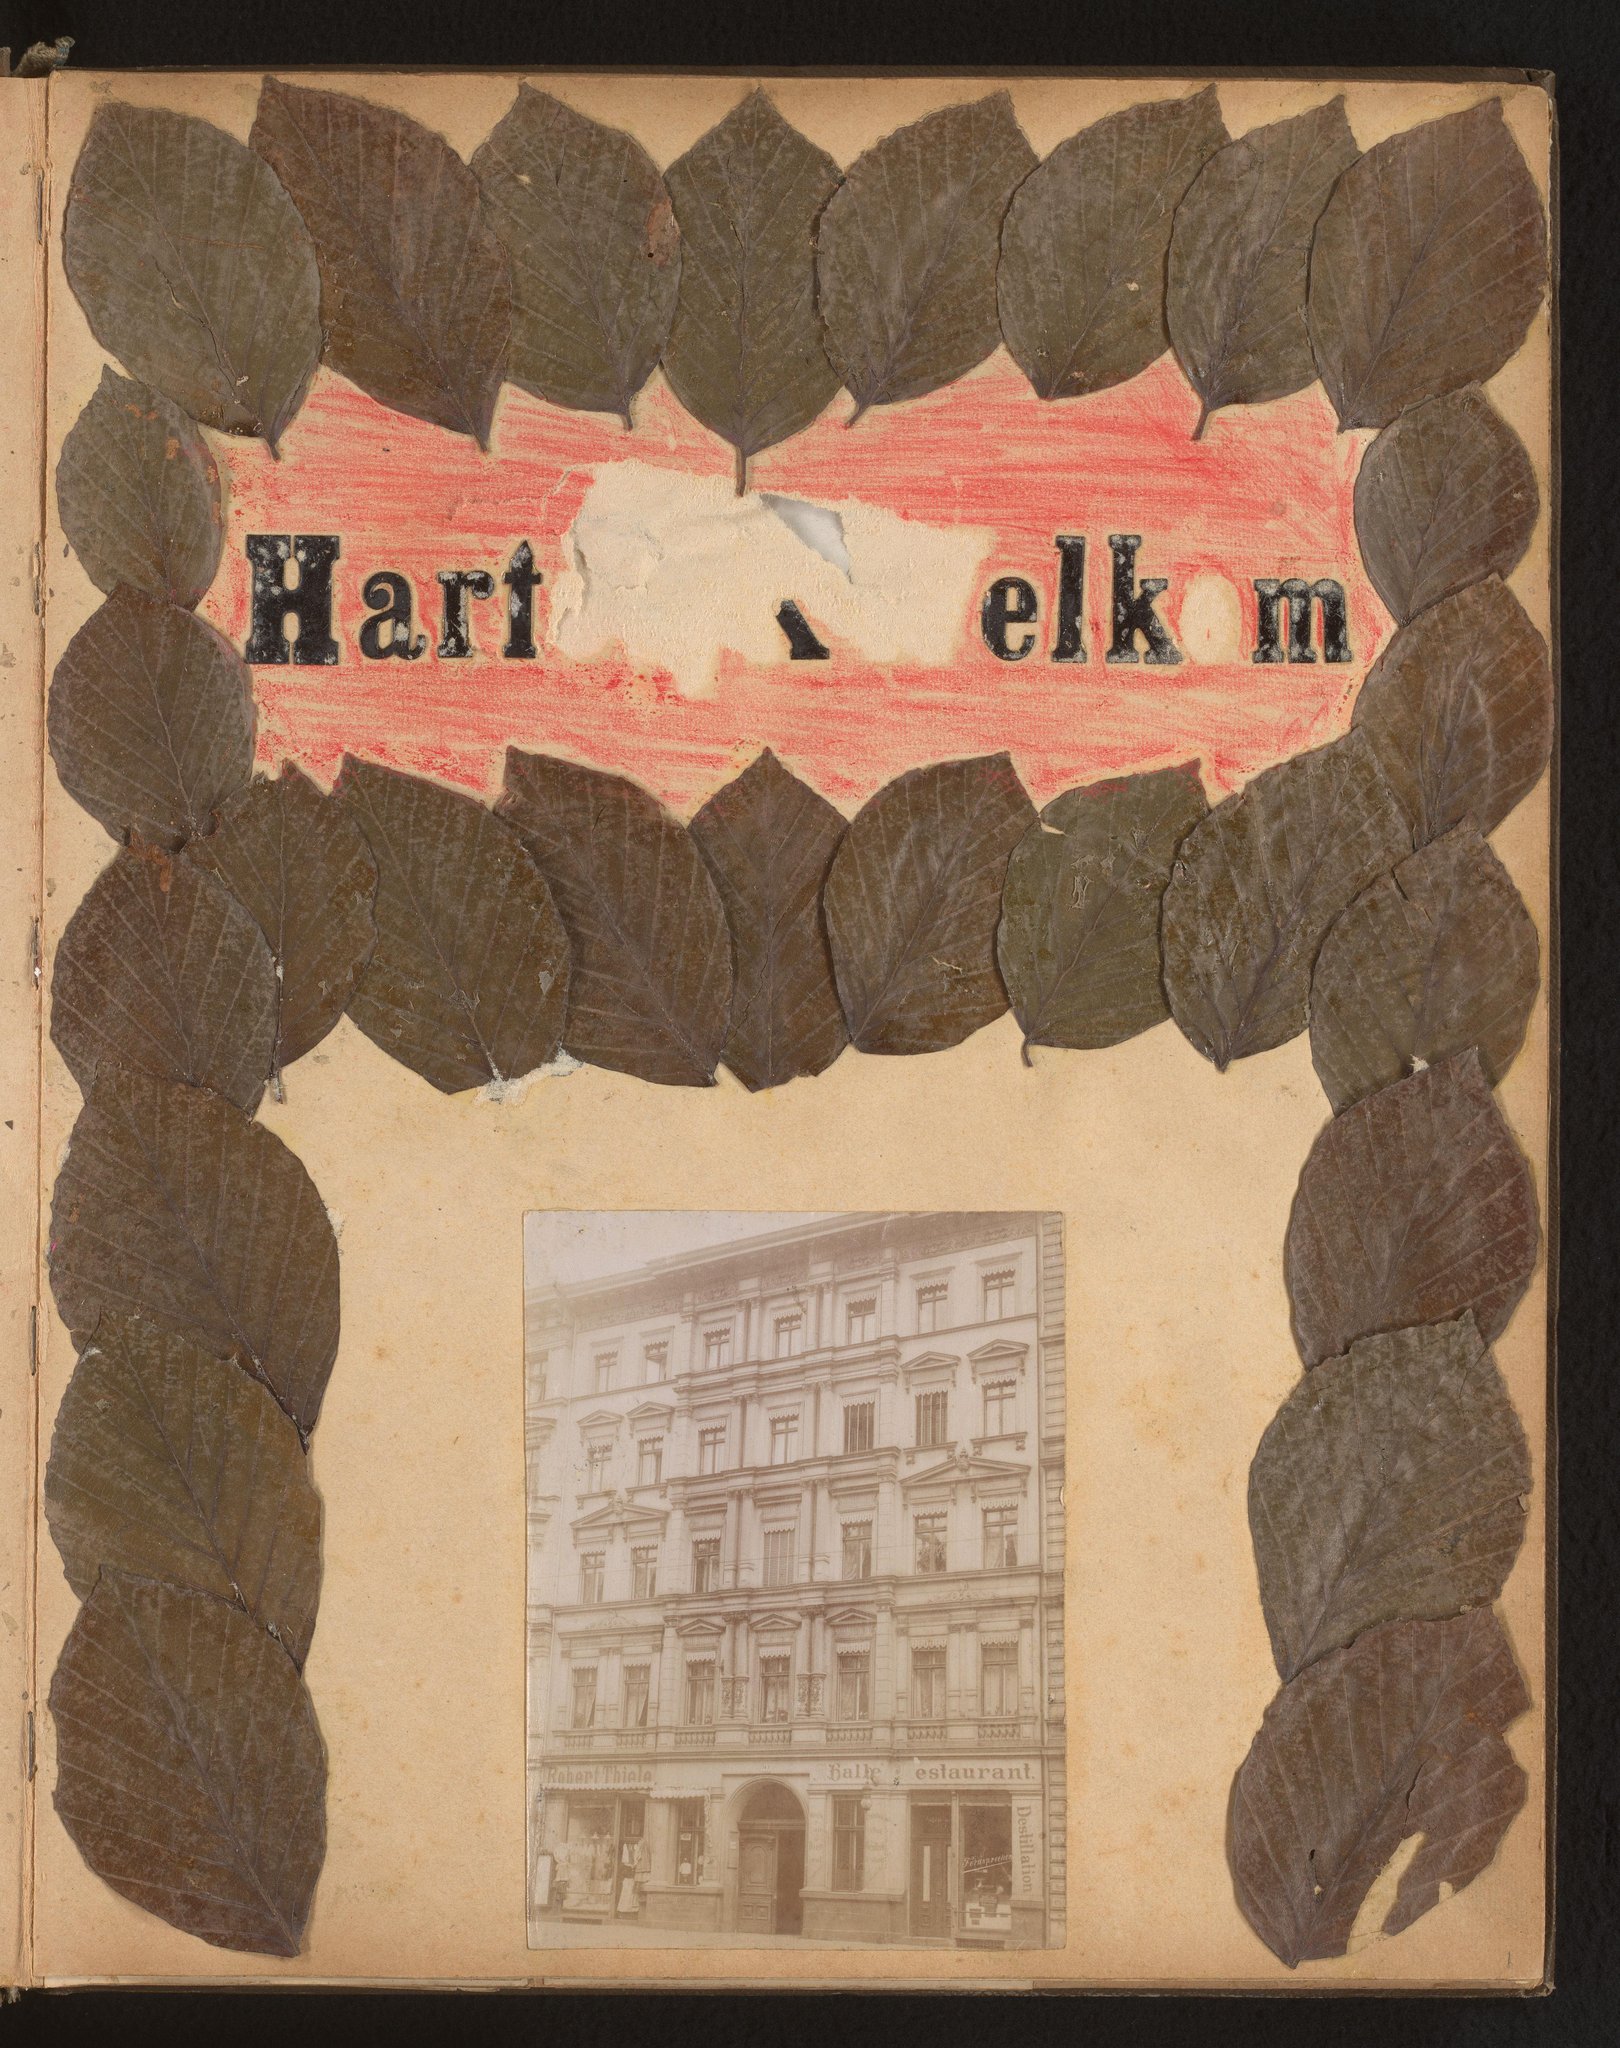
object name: photograph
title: Huisfaçade in Berlijn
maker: Anonymous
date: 1896-1901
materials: paper, pencil, plant material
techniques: albumen print, writing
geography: berlin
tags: urban housing, berlin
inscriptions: inscription: ‘Hart[...]k [...]elkom’